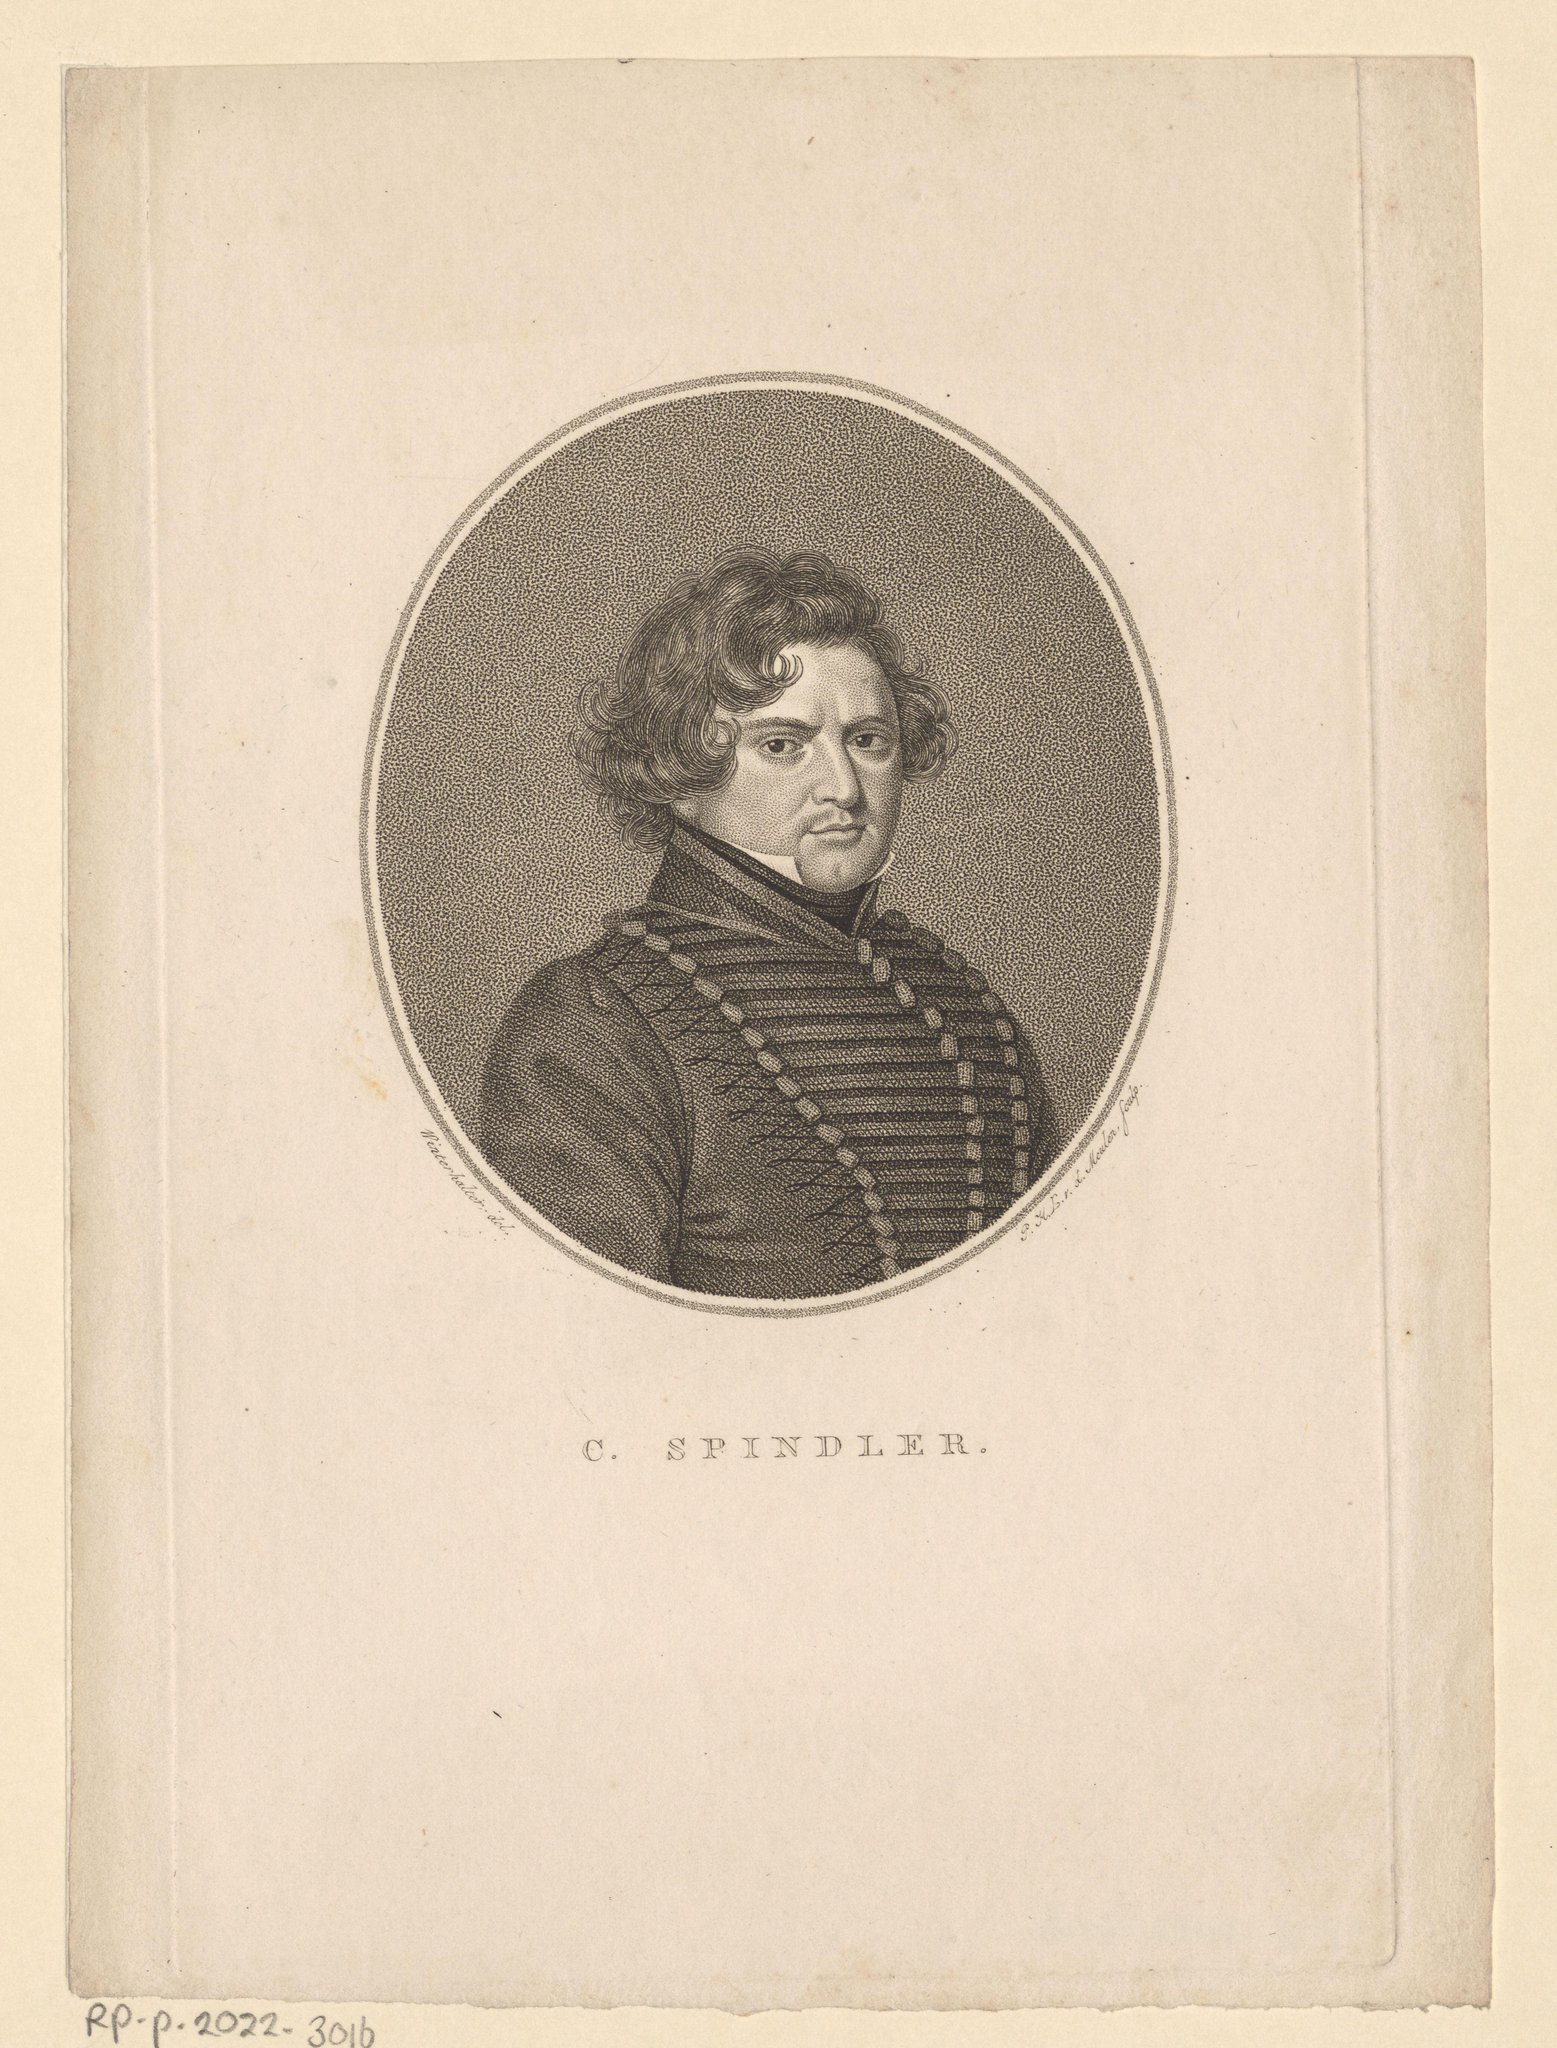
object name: print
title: Portret van Karl Spindler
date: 1826-1858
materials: paper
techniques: etching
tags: historical persons, portrait of a writer